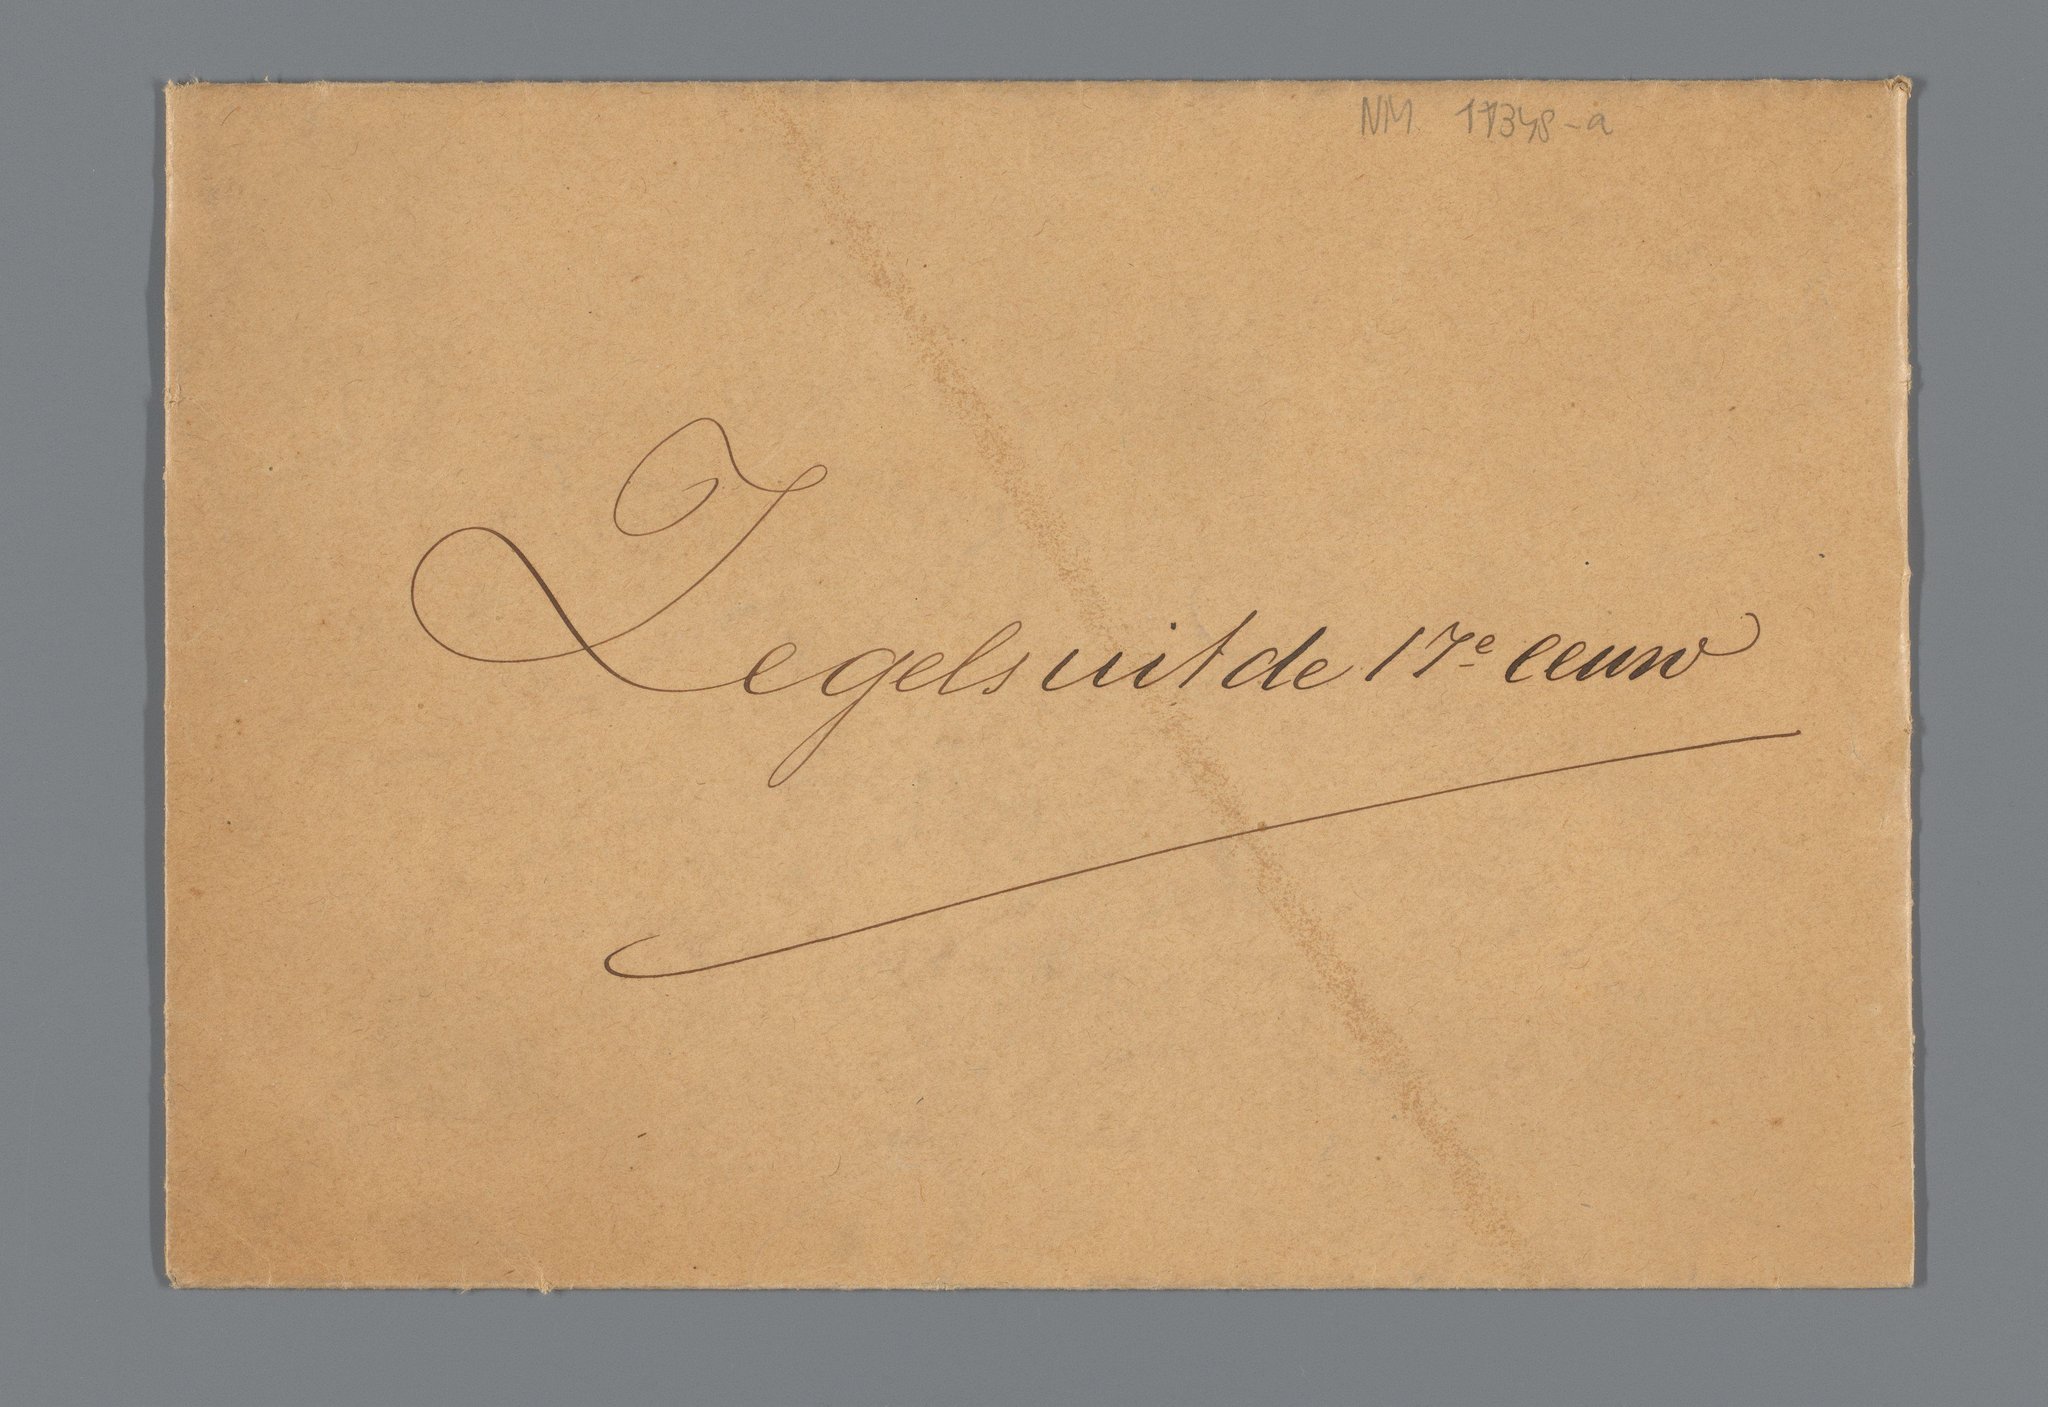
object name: zegelafdruk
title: Zegelafdrukken uit 1600-1699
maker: Anonymous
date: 1633-1700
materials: ink, paper, parchment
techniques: blind stamped, printing, writing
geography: netherlands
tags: netherlands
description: Melinexmap met 82 losse uitgeknipte zegels uit de 17e eeuw, afkomstig van officiële Nederlandse overheidsinstanties. Onderdeel van reeks mappen met zegels en documenten (NG-NM-11348-A t/m I).